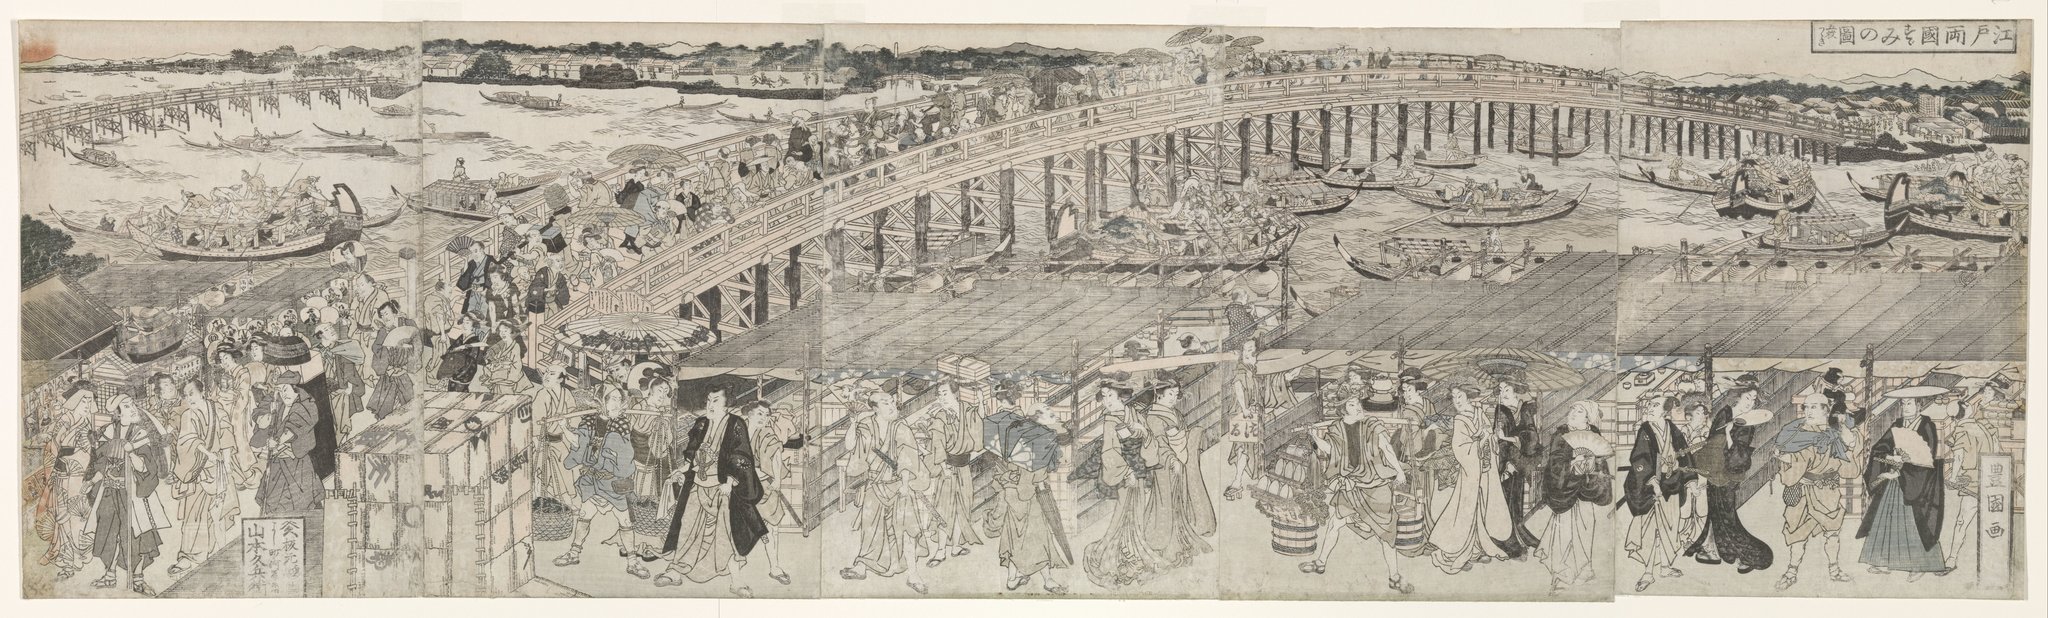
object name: print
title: View: Enjoying the Evening Breeze at the Ryogoku Bridge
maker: utagawa toyokuni (i)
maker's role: print maker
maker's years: 1769-1825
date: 1811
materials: paper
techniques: woodcut, nishiki e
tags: rowing-boat, canoe, etc., bridge, festivities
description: At his death Breitner owned a collection of 45 Japanese prints, including this quintych. In the catalogue of his estate the work is described as ‘A Japanese print, representing a water festival.’ It is not known where he bought the prints, but there were plenty of possibilities. For instance, in 1894 an exhibition of Japanese prints was held at Arti et Amicitiae, the artists’ association of which Breitner was an active member.